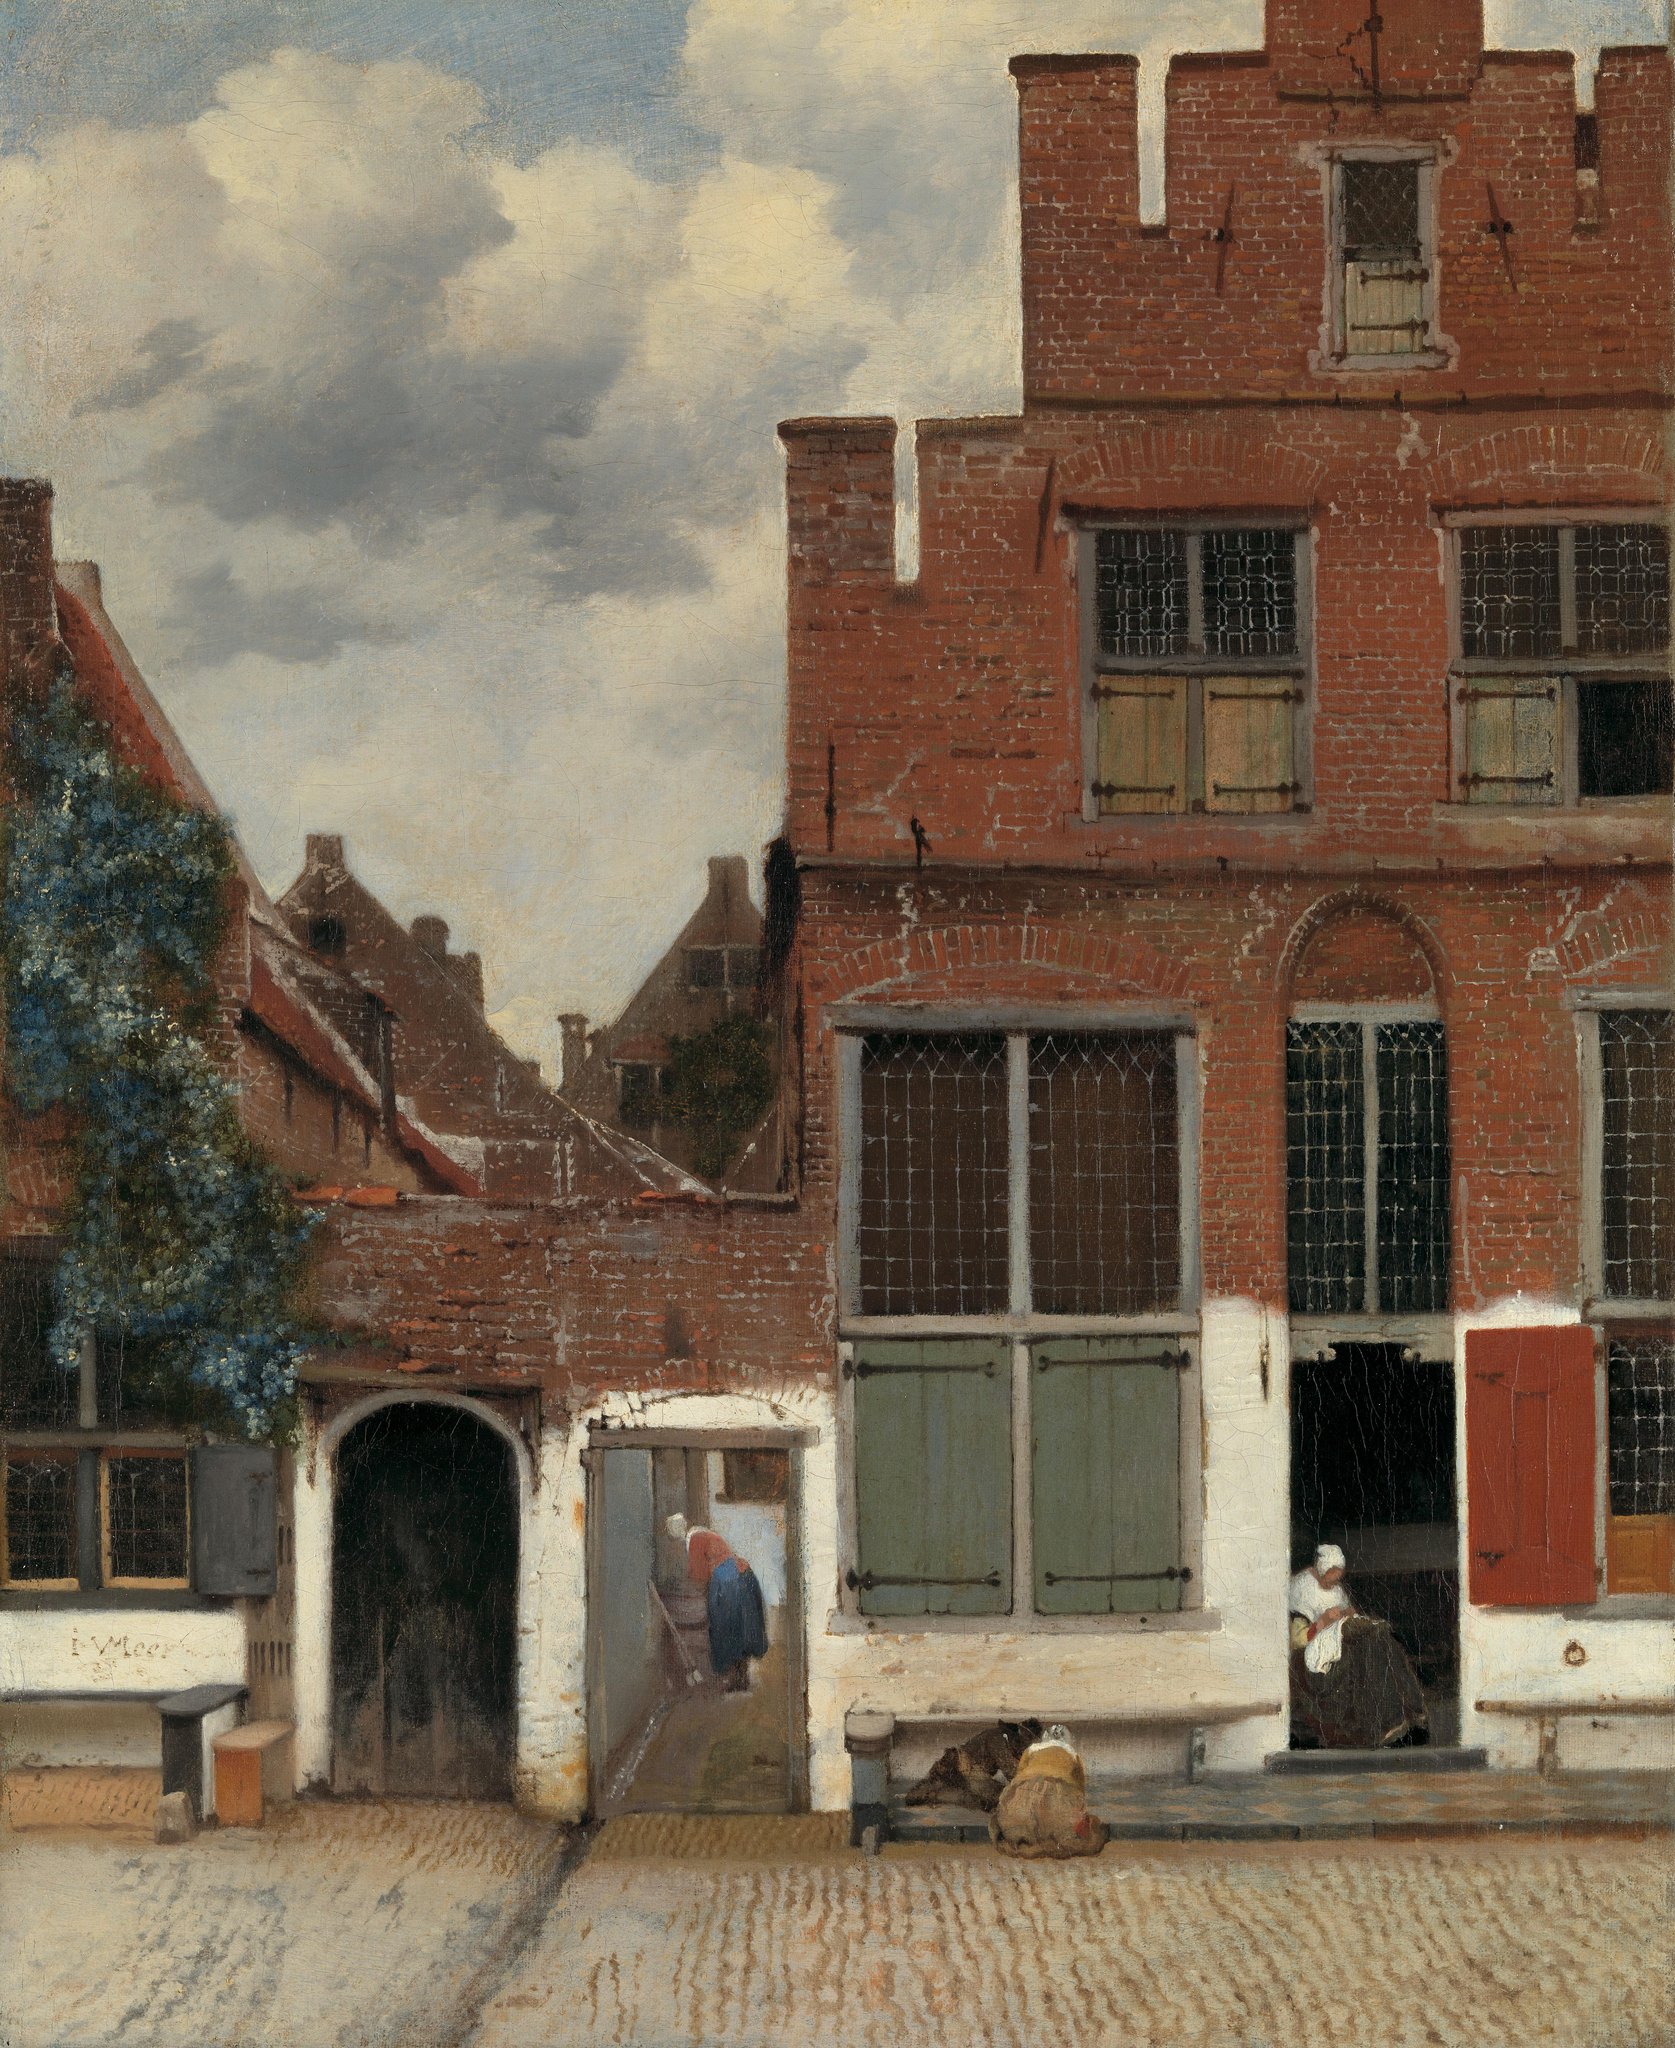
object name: painting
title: View of Houses in Delft, Known as The Little Street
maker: johannes vermeer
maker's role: draughtsman, painter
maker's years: 1632-1675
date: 1658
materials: canvas, oil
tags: home sewing; repair of clothes, children's games and plays (+ out of doors (sports, games, etc.)), civic architecture; edifices; dwellings, street, delft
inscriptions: signature: ‘I. VMeer’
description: This is an unusual painting in Vermeer’s oeuvre, and remarkable for its time as a portrait of ordinary houses. The composition is as exciting as it is balanced. The old walls with their bricks, whitewash, and cracks are almost tangible. The location is Vlamingstraat 40–42 in Delft. Vermeer’s aunt Ariaentgen Claes lived in the house at the right, with her children, from around 1645 until her death in 1670.